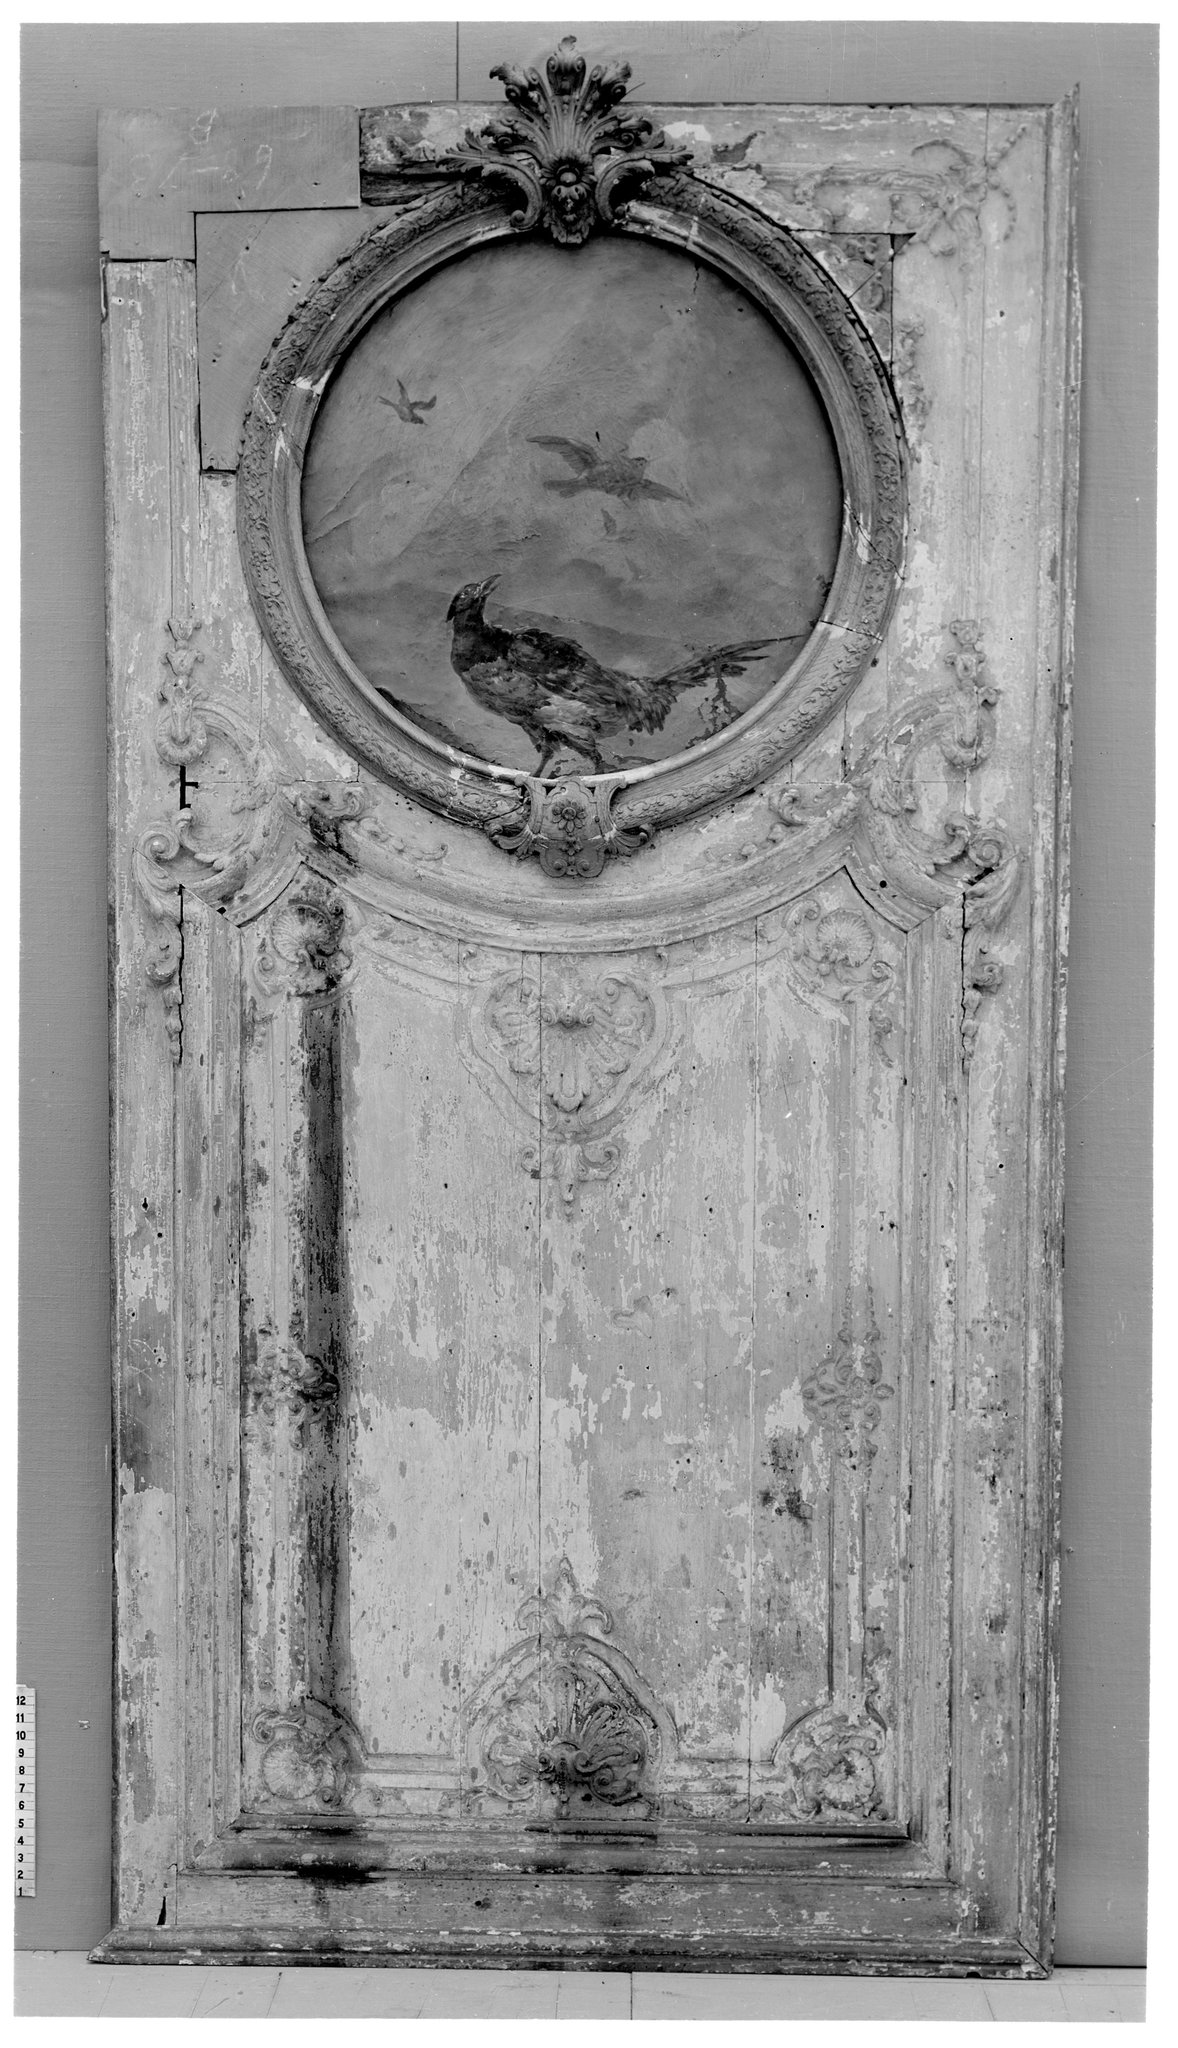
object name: wall panel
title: Wall panel (part of a set)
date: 1701-1725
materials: wood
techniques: carving, painting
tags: birds